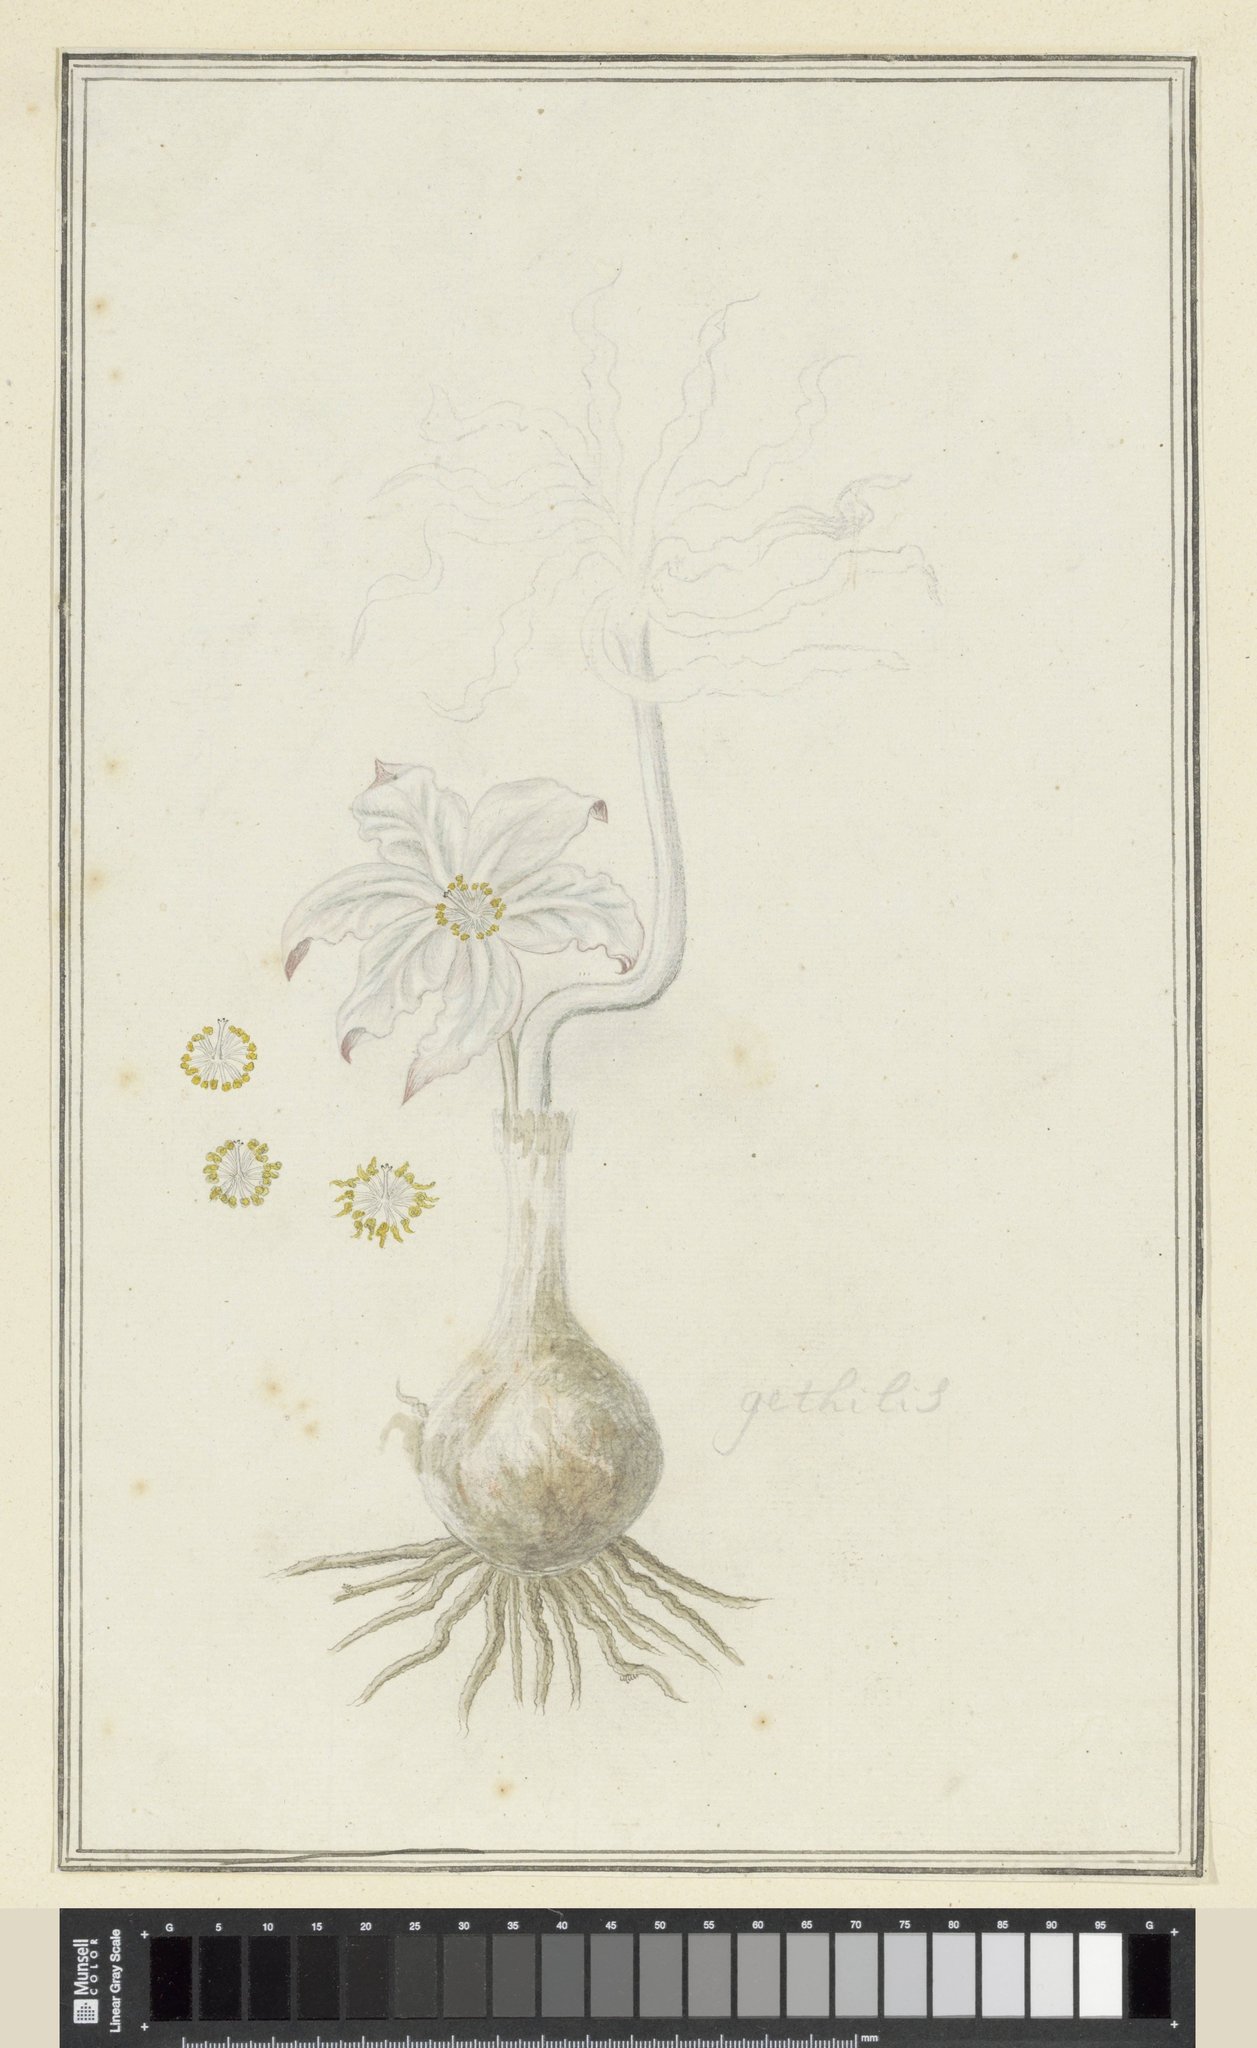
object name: album leaf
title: Gethyllis britteniana Baker (Kukumakranka)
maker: robert jacob gordon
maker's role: draughtsman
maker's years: 1743-1795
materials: chalk, ink, paper, pencil, watercolor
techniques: brush, pen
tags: plants; vegetation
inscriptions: annotation: ‘gethilis’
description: De tekening is gemaakt voor of tijdens een van Gordon's vier expedities door de Kaapprovincie, van oktober 1777 tot maart 1786. Sommige (soort)namen kunnen zijn gewijzigd, gezien reorganisatie in plantentaxonomie gedurende de afgelopen jaren.